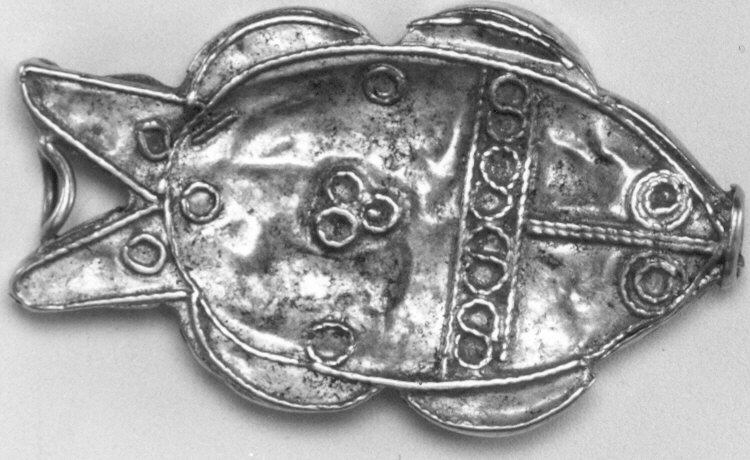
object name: element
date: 1001-1200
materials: gold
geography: iran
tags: fish